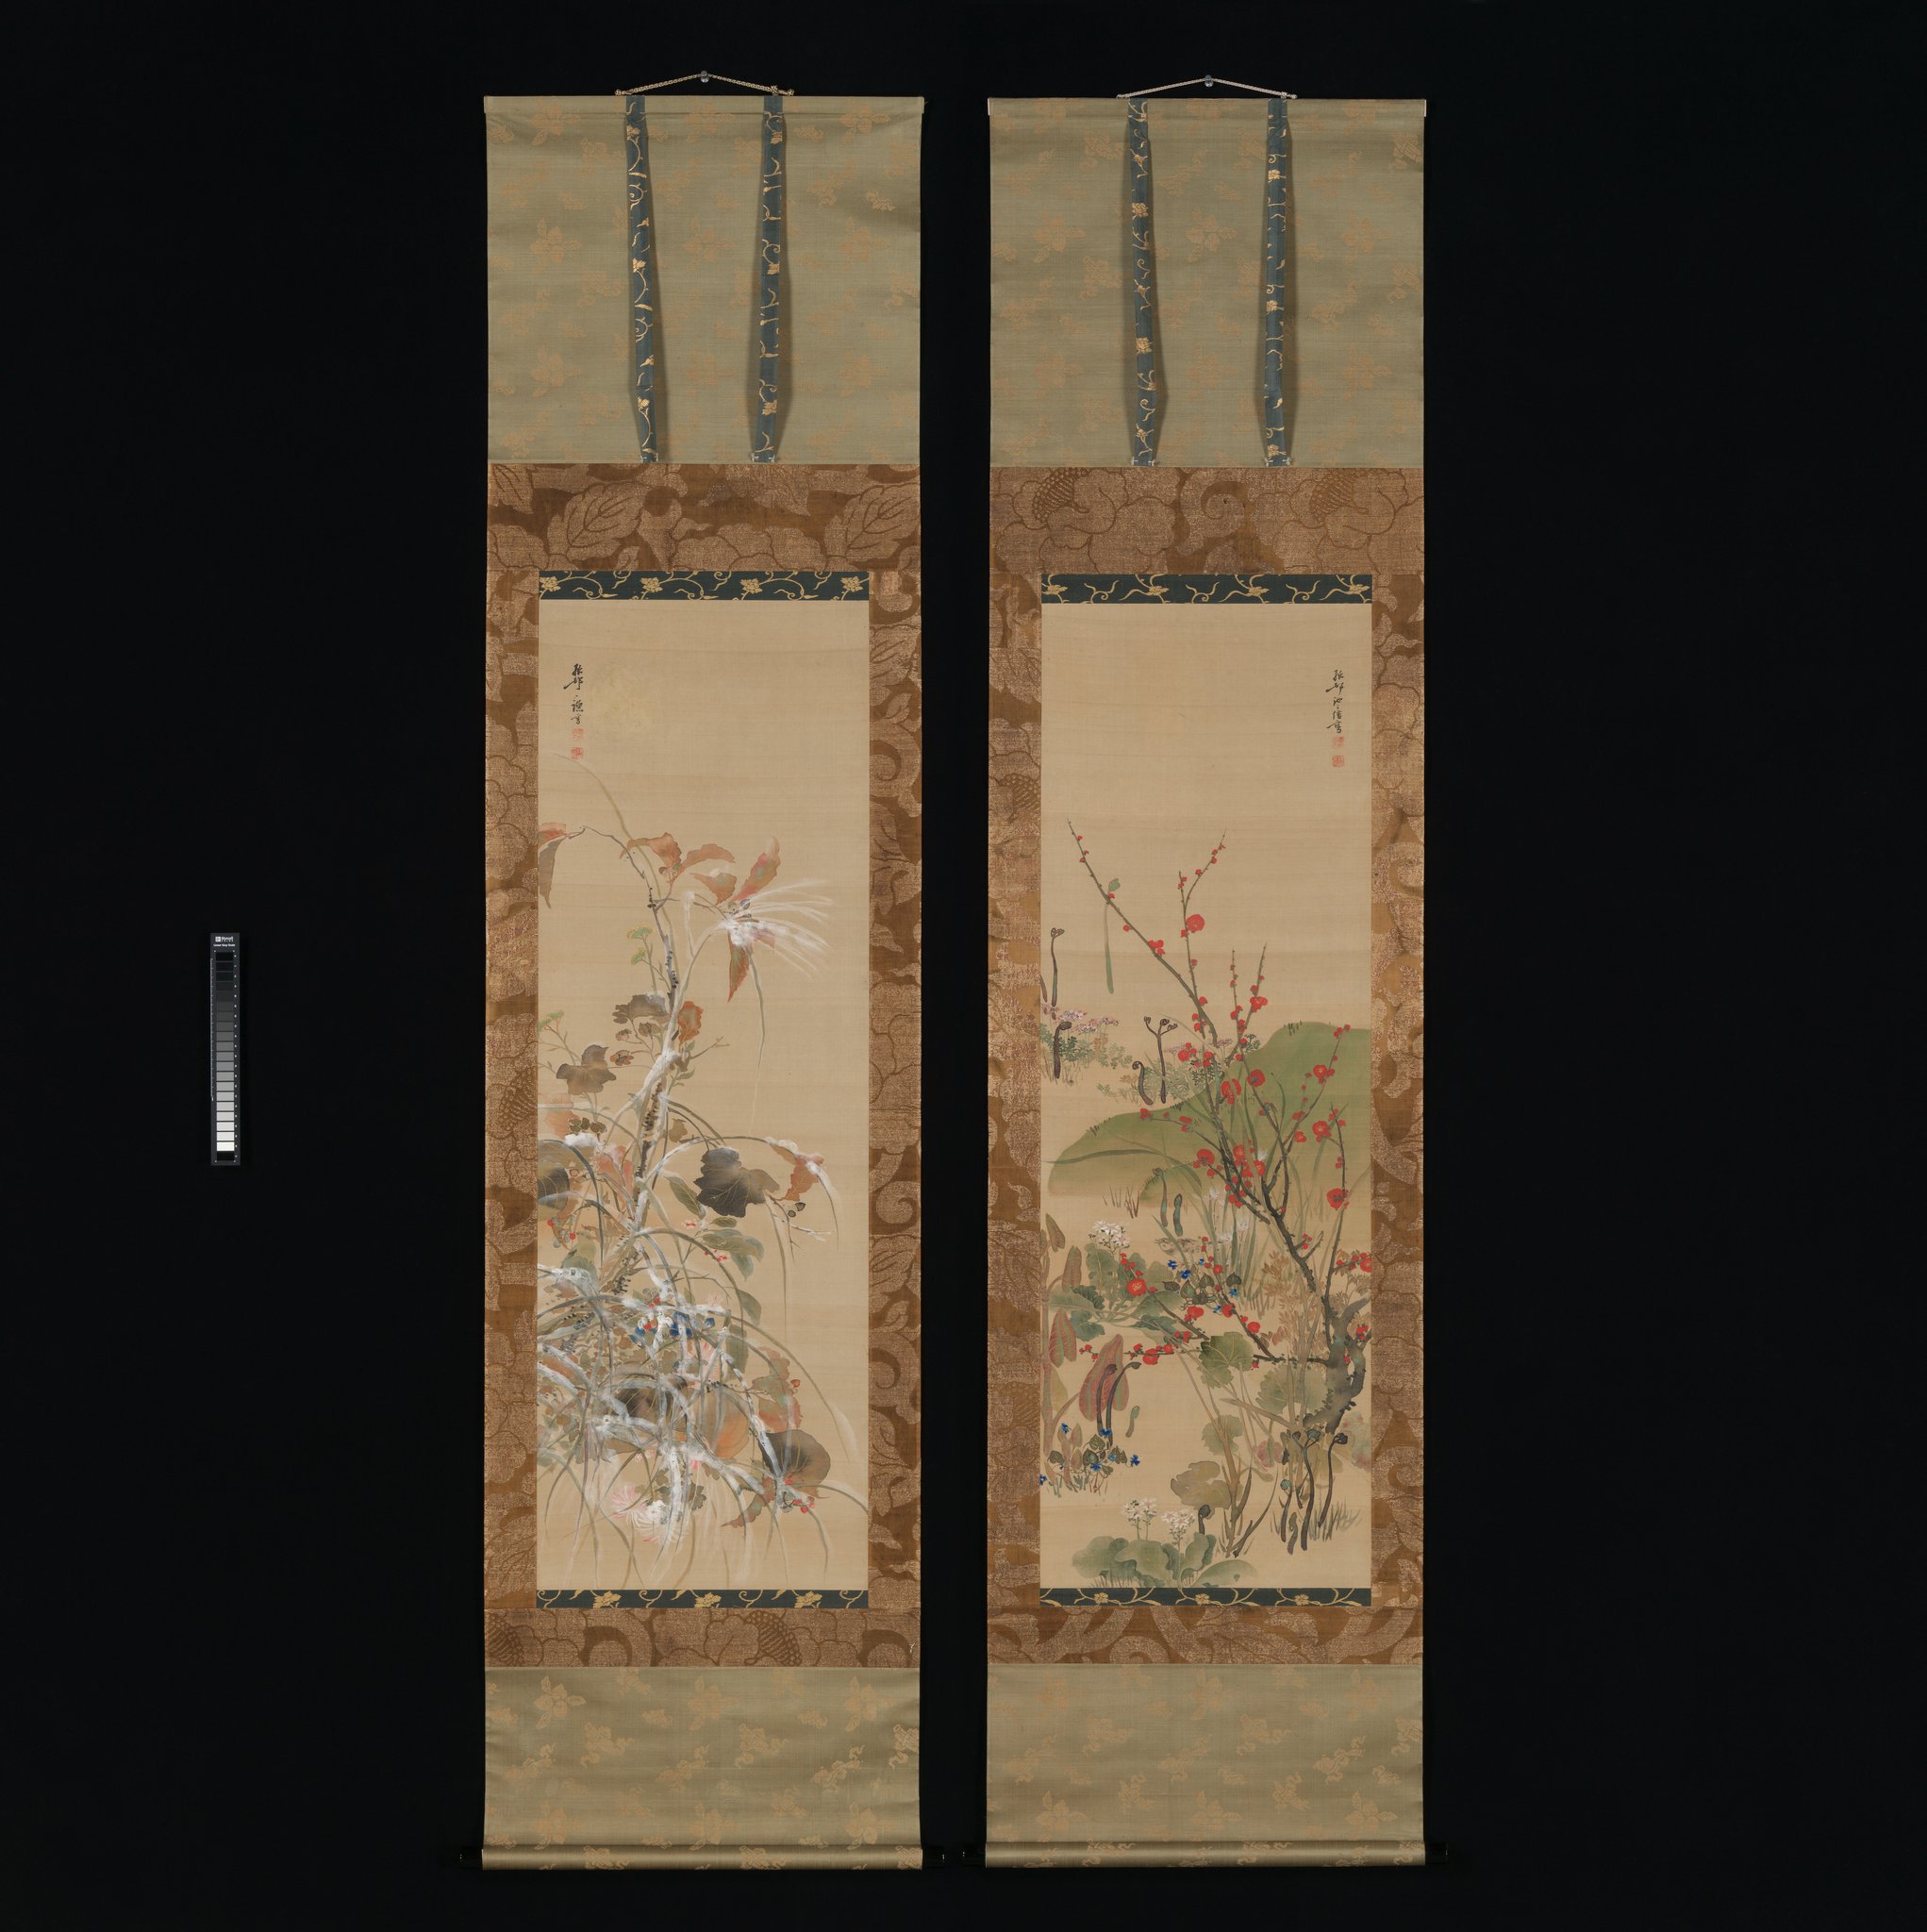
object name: hanging scroll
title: Flowers and Birds of the Four Seasons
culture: japanese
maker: ikeda koson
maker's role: artist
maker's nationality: japanese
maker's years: 1803-1868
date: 1834-1866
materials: gold, ink, silk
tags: flowers